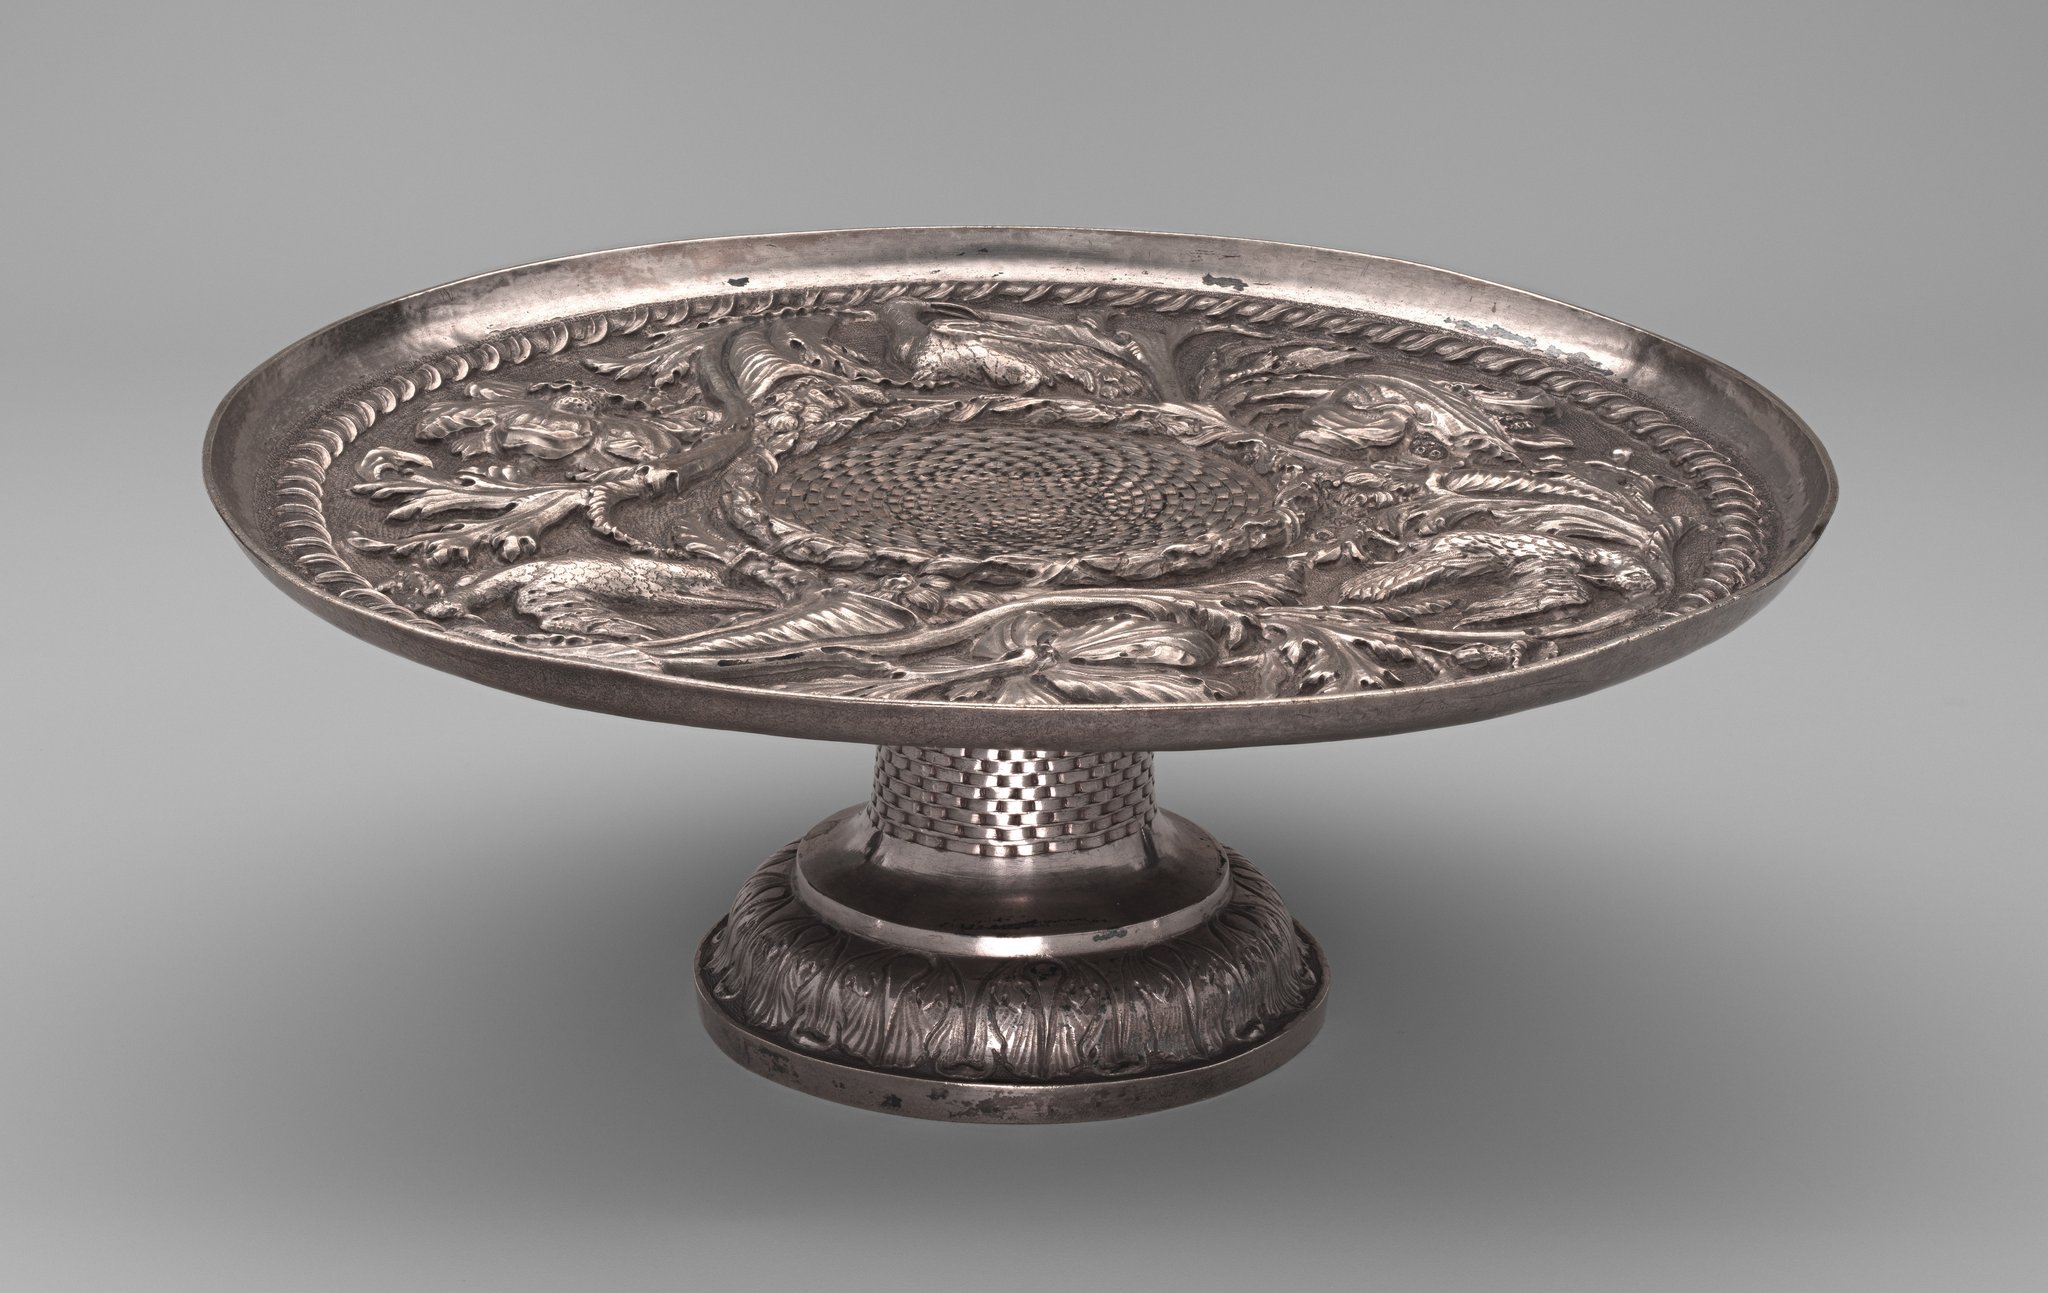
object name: tazza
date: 1651-1700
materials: silver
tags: birds,flowers